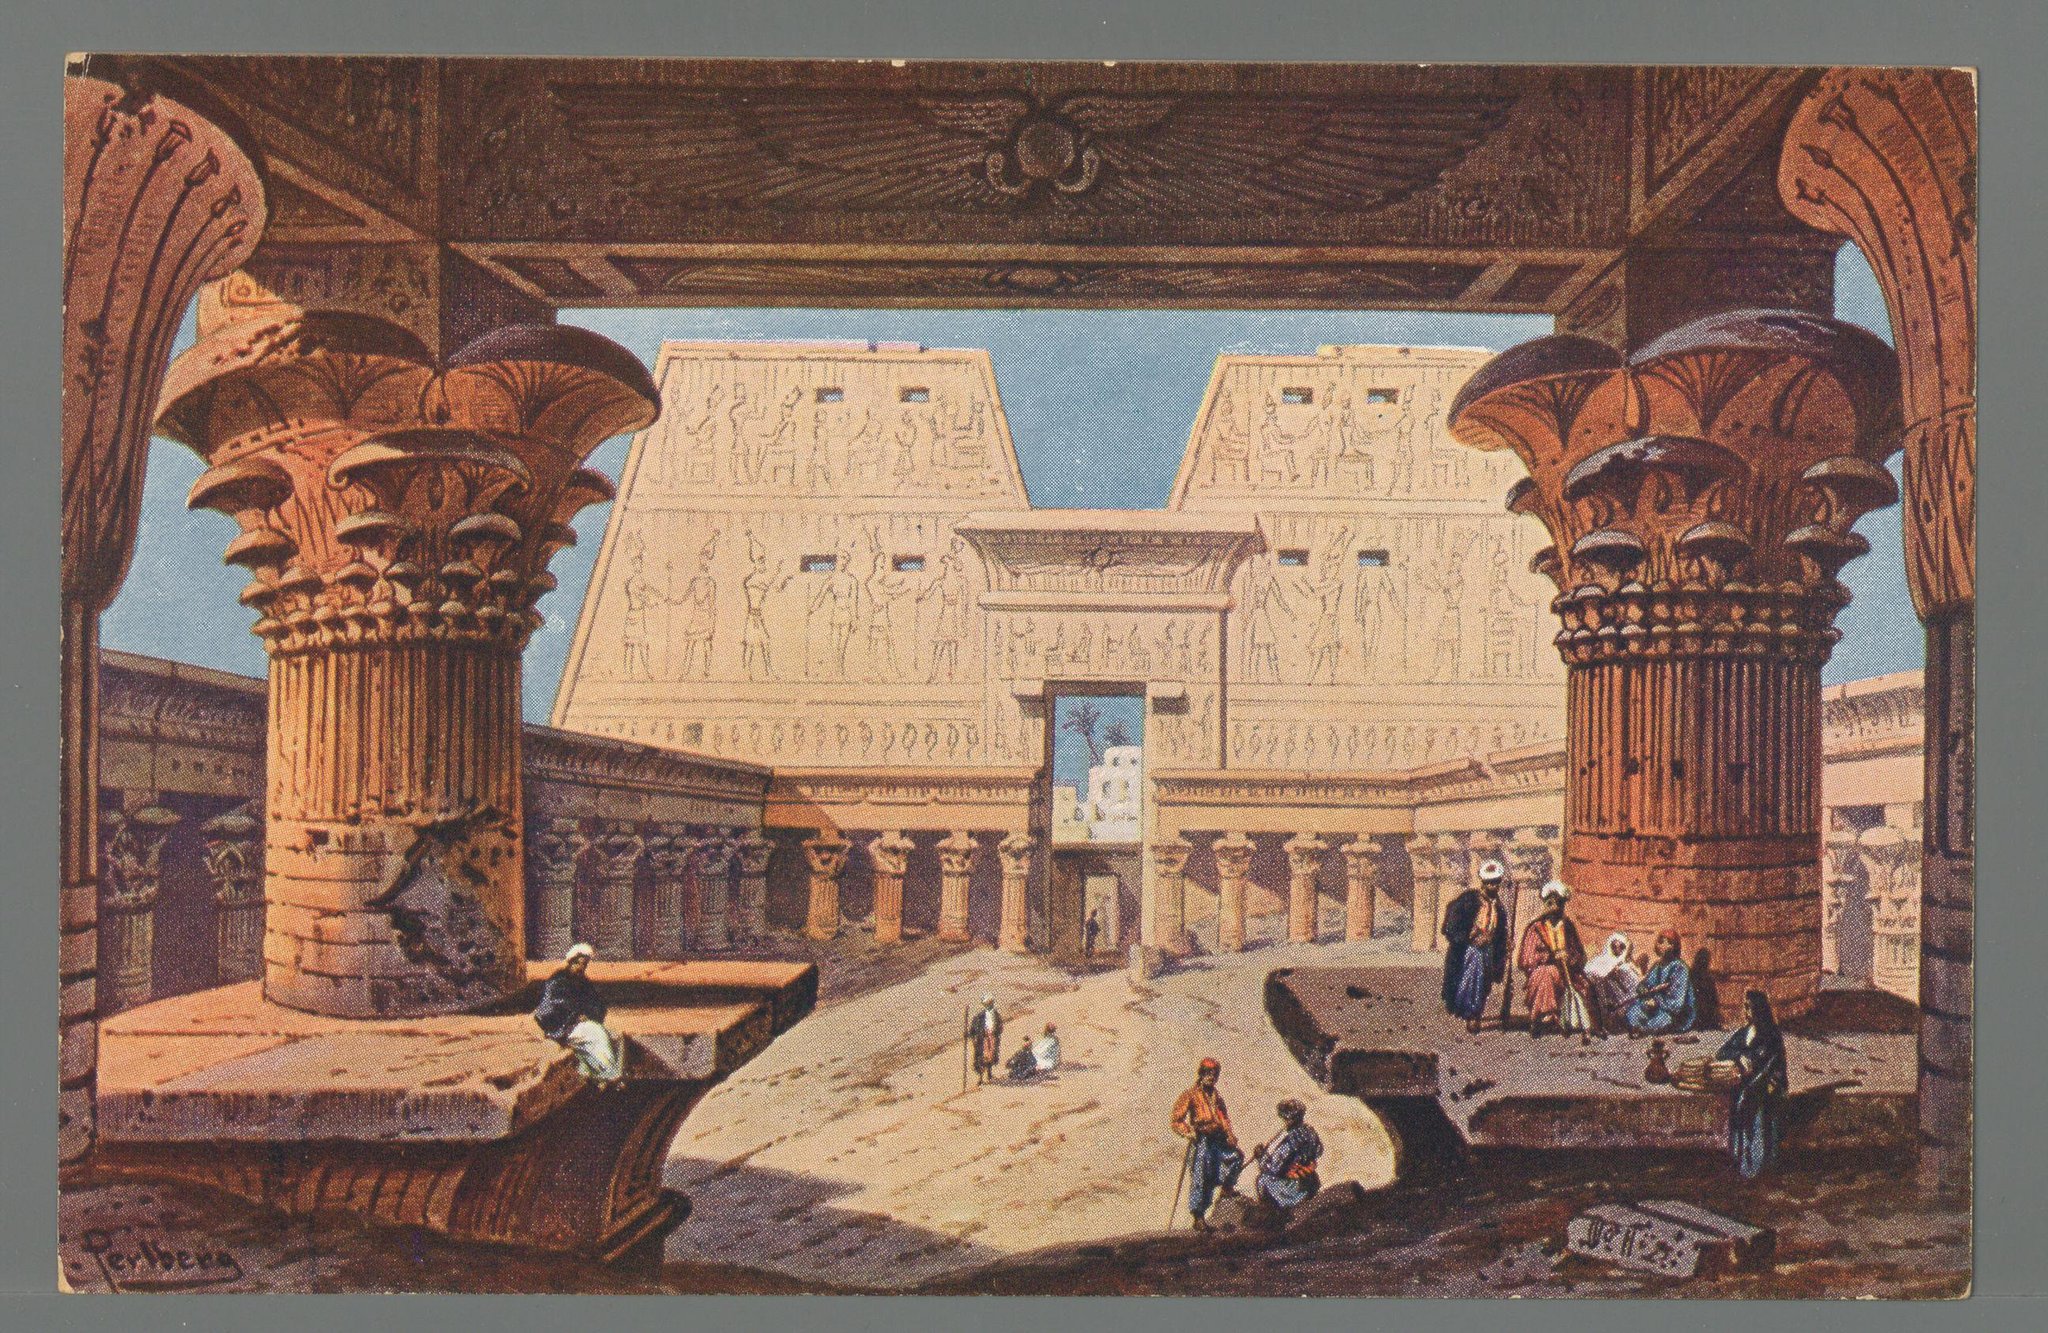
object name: ansichtkaart, prentbriefkaart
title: Temple d'Edfou / Temple of Edfoo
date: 1907-1930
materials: cardboard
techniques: color autotype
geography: dresden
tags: temple, shrine ~ egyptian religion, column, pillar ~ architecture, egyptian hieroglyphs